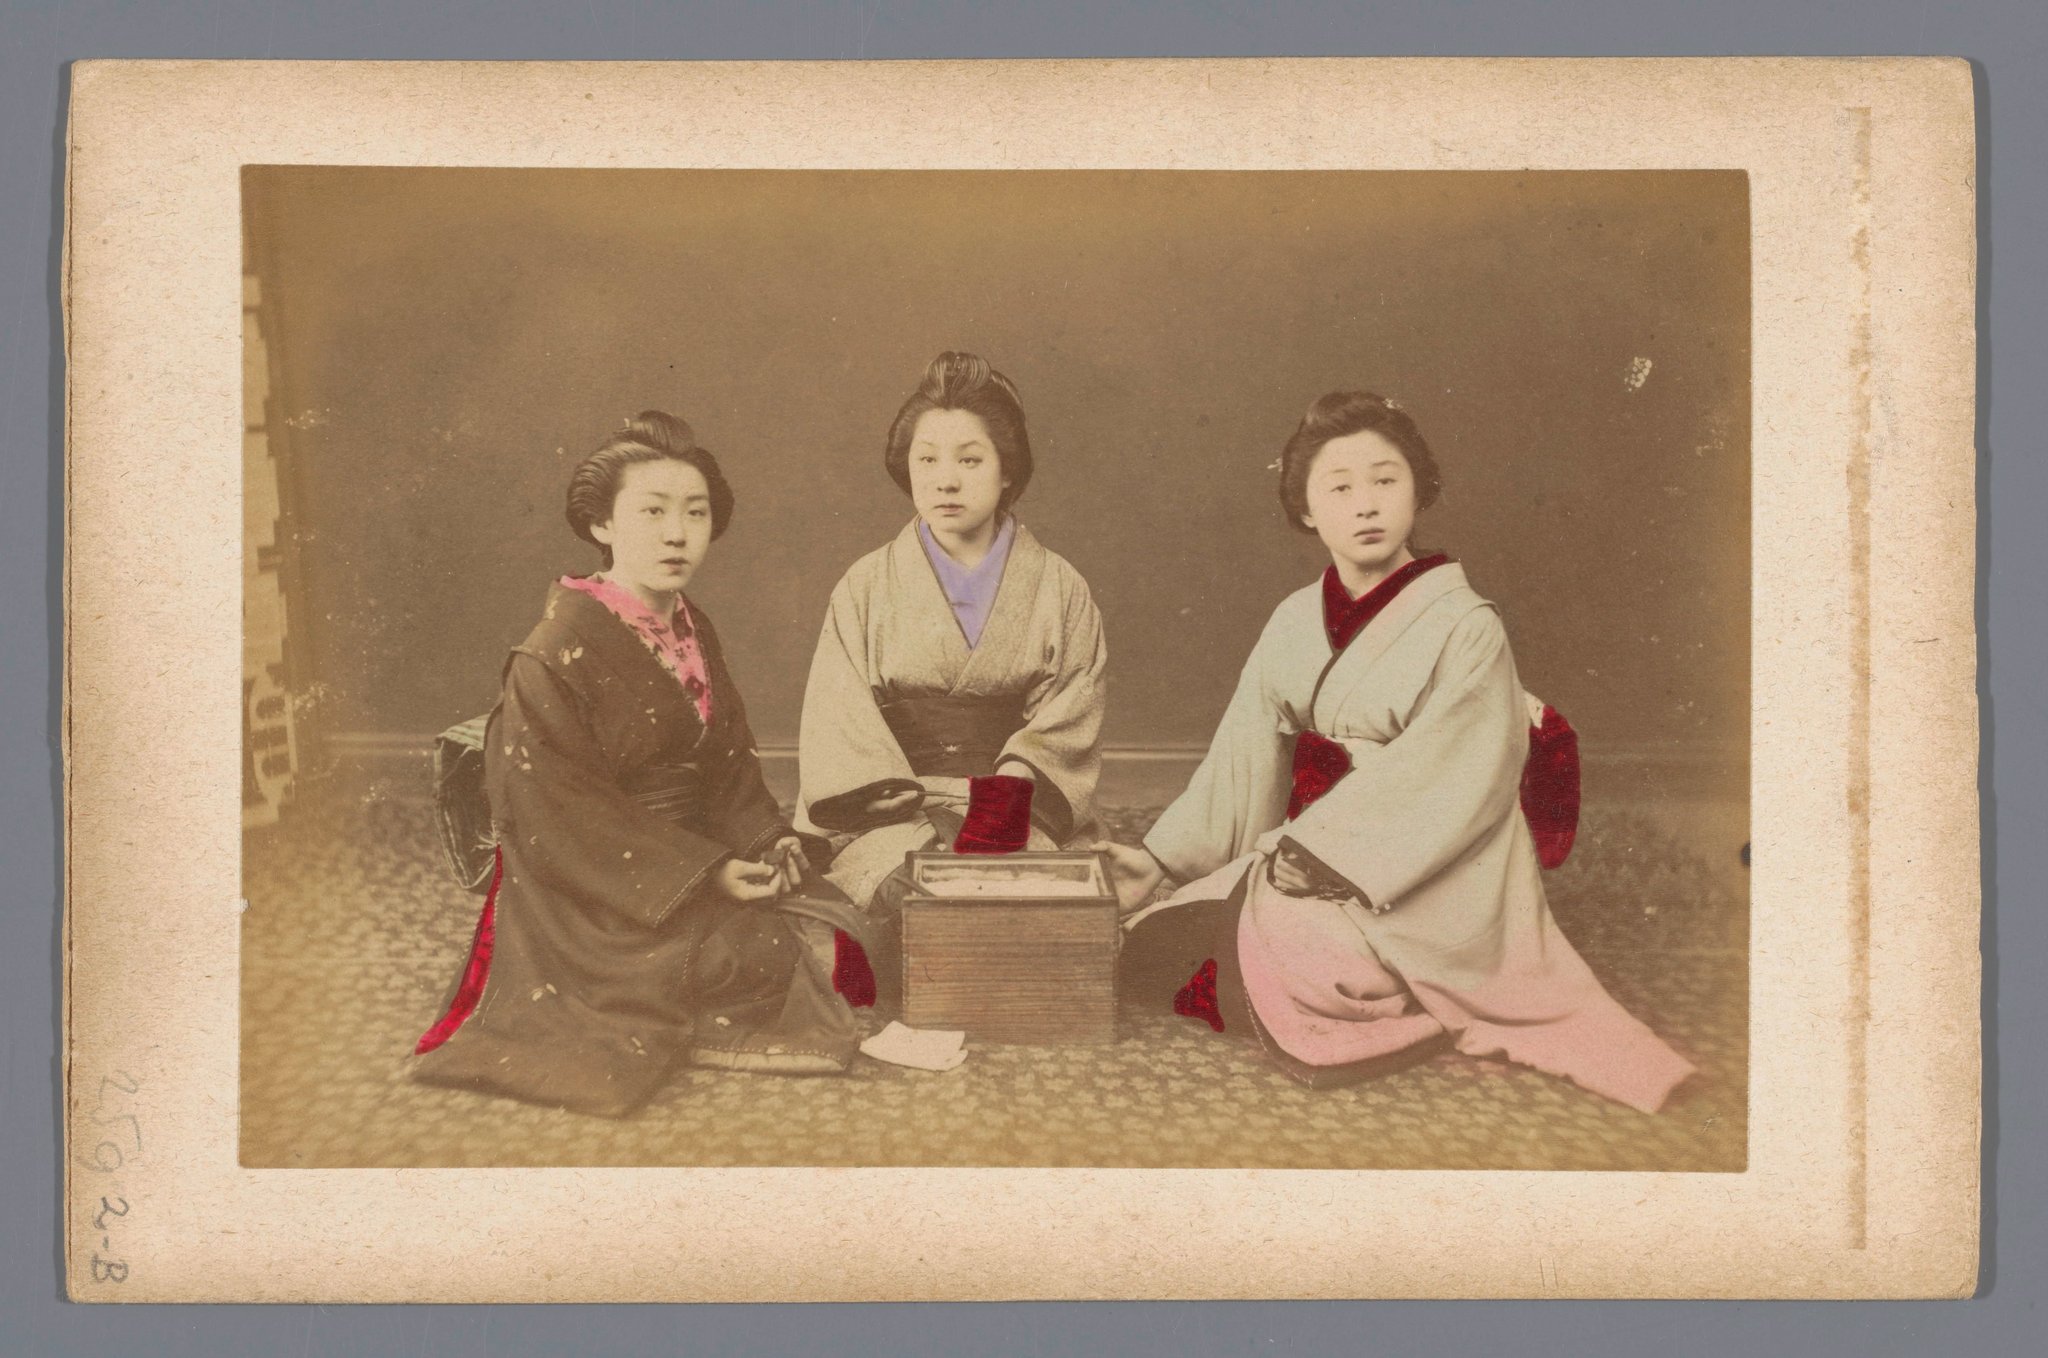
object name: photograph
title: Groepsportret van drie jonge onbekende Japanse vrouwen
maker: Anonymous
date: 1860-1900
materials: cardboard, paper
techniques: albumen print, hand coloring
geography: japan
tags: adolescent, young woman, maiden, anonymous historical persons portrayed in a group, in a group-portrait, japan